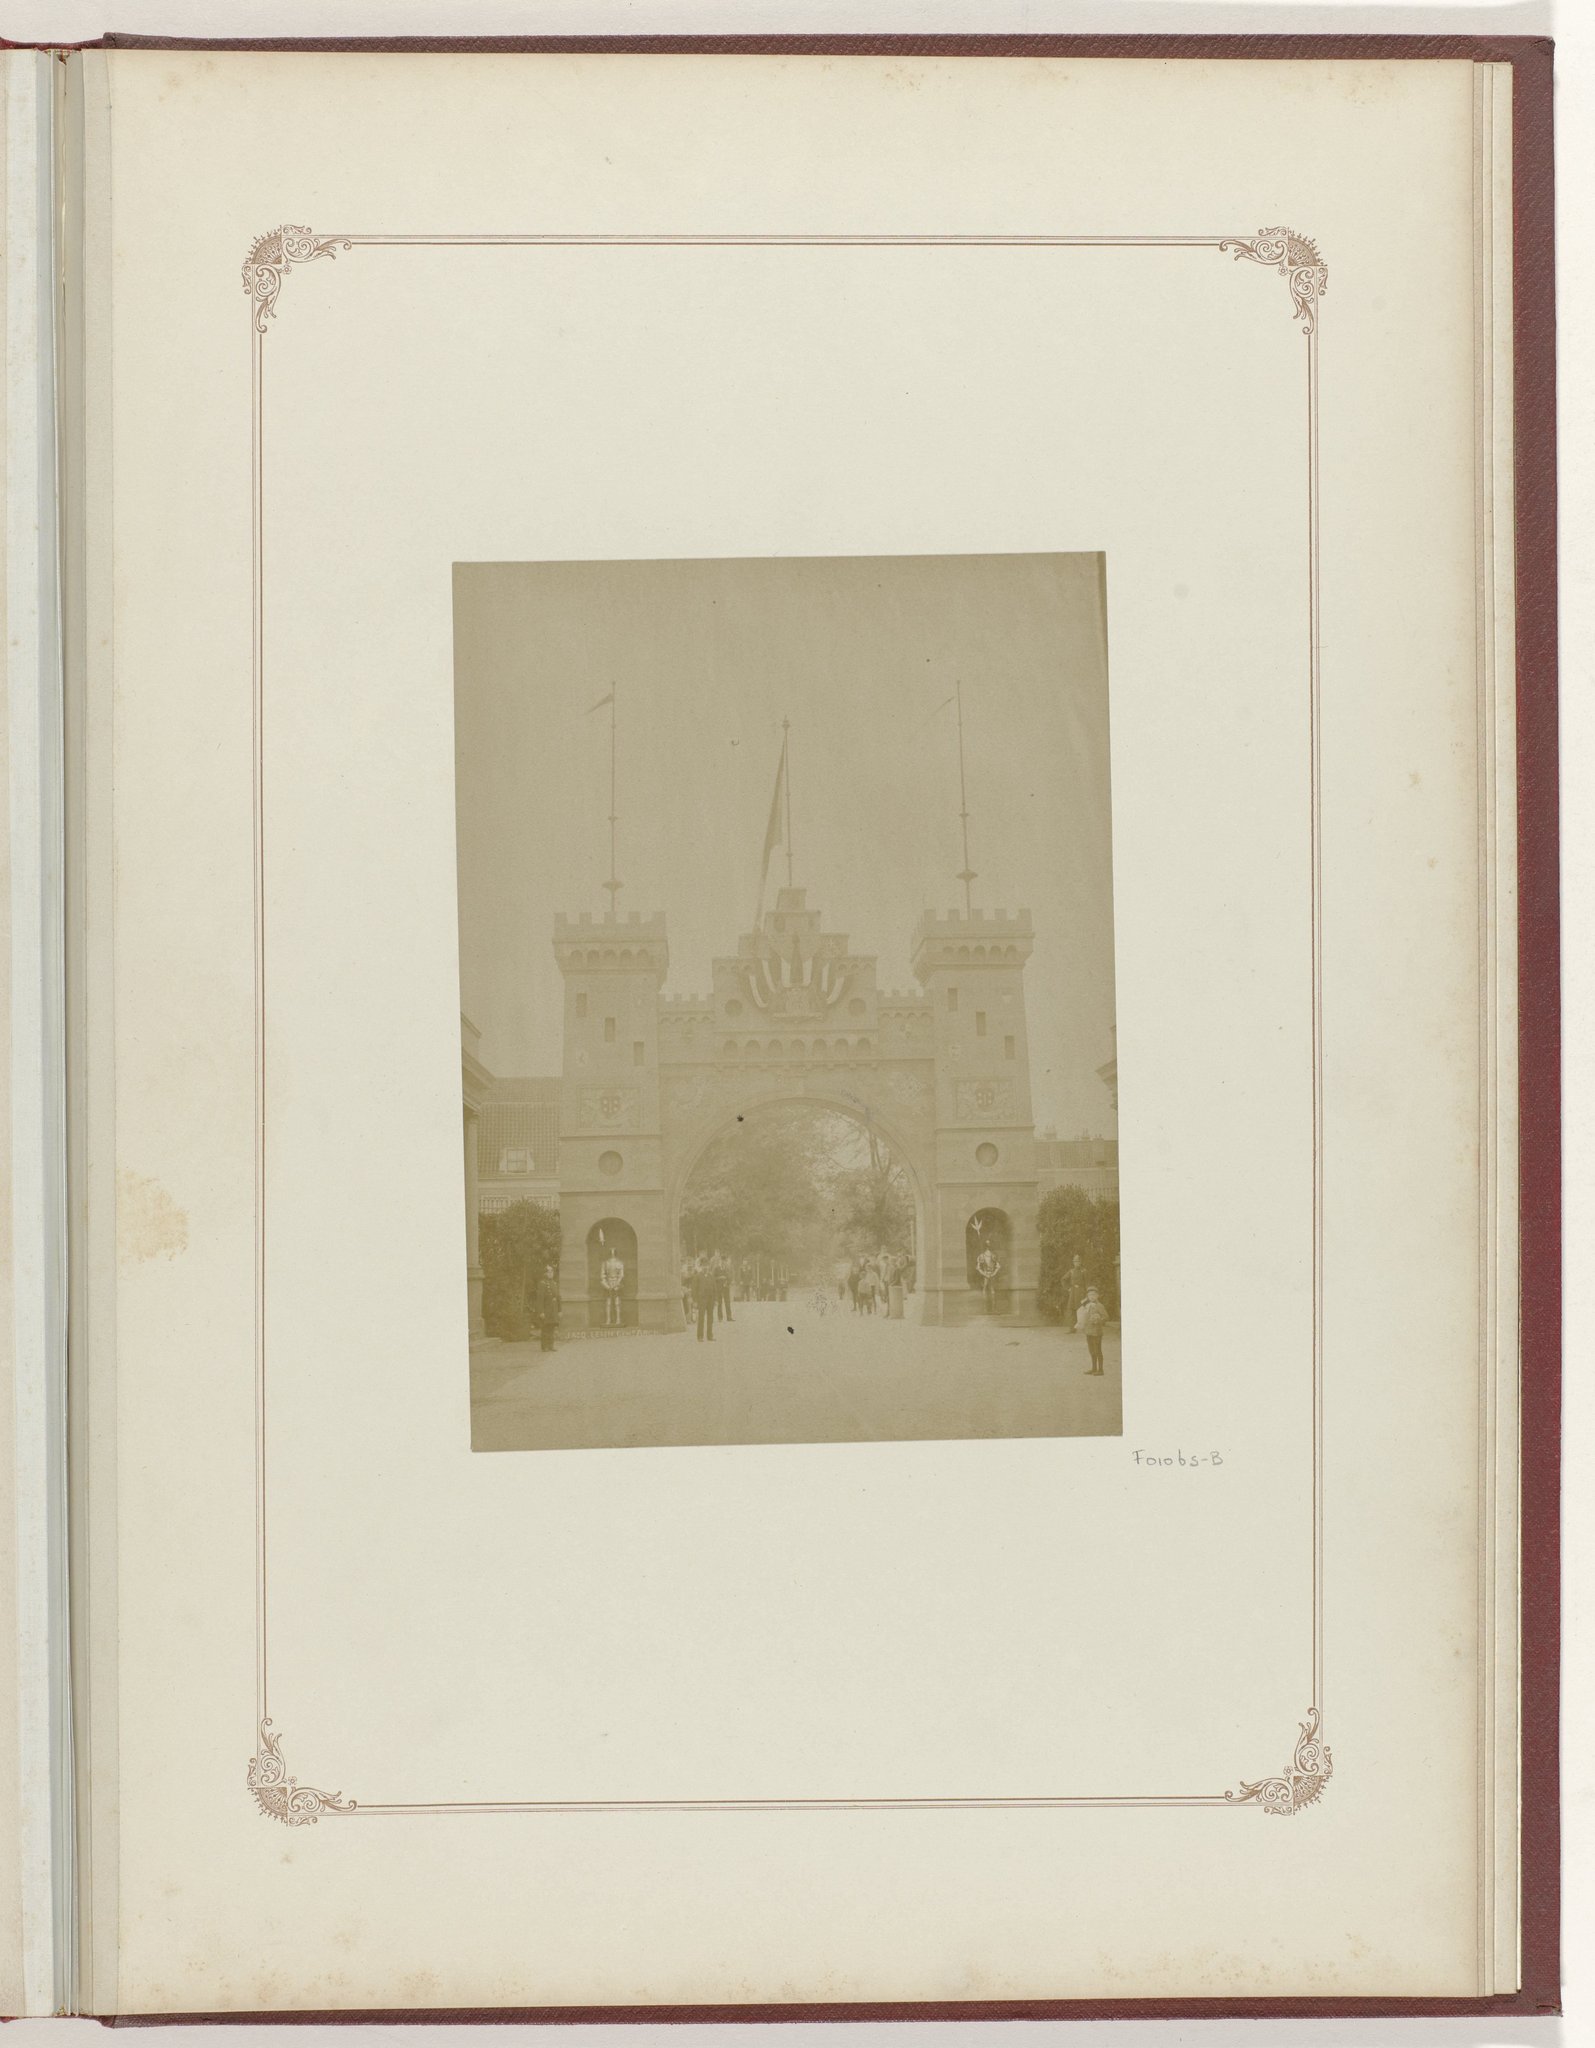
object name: photograph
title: Eerepoort bij de Groote Houtbrug, toegang gevende naar den Hout/ ontworpen door Jacques Leijh, Gemeente-Architect van haarlem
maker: Anonymous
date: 1892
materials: cardboard, photographic support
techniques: albumen print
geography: haarlem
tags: triumphal arch, public festivities, city-gate, haarlem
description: Erepoort ter gelegenheid van het bezoek van koningin-regentes Emma aan Haarlem op 23 september 1892. Deze foto maakt deel uit van een album.